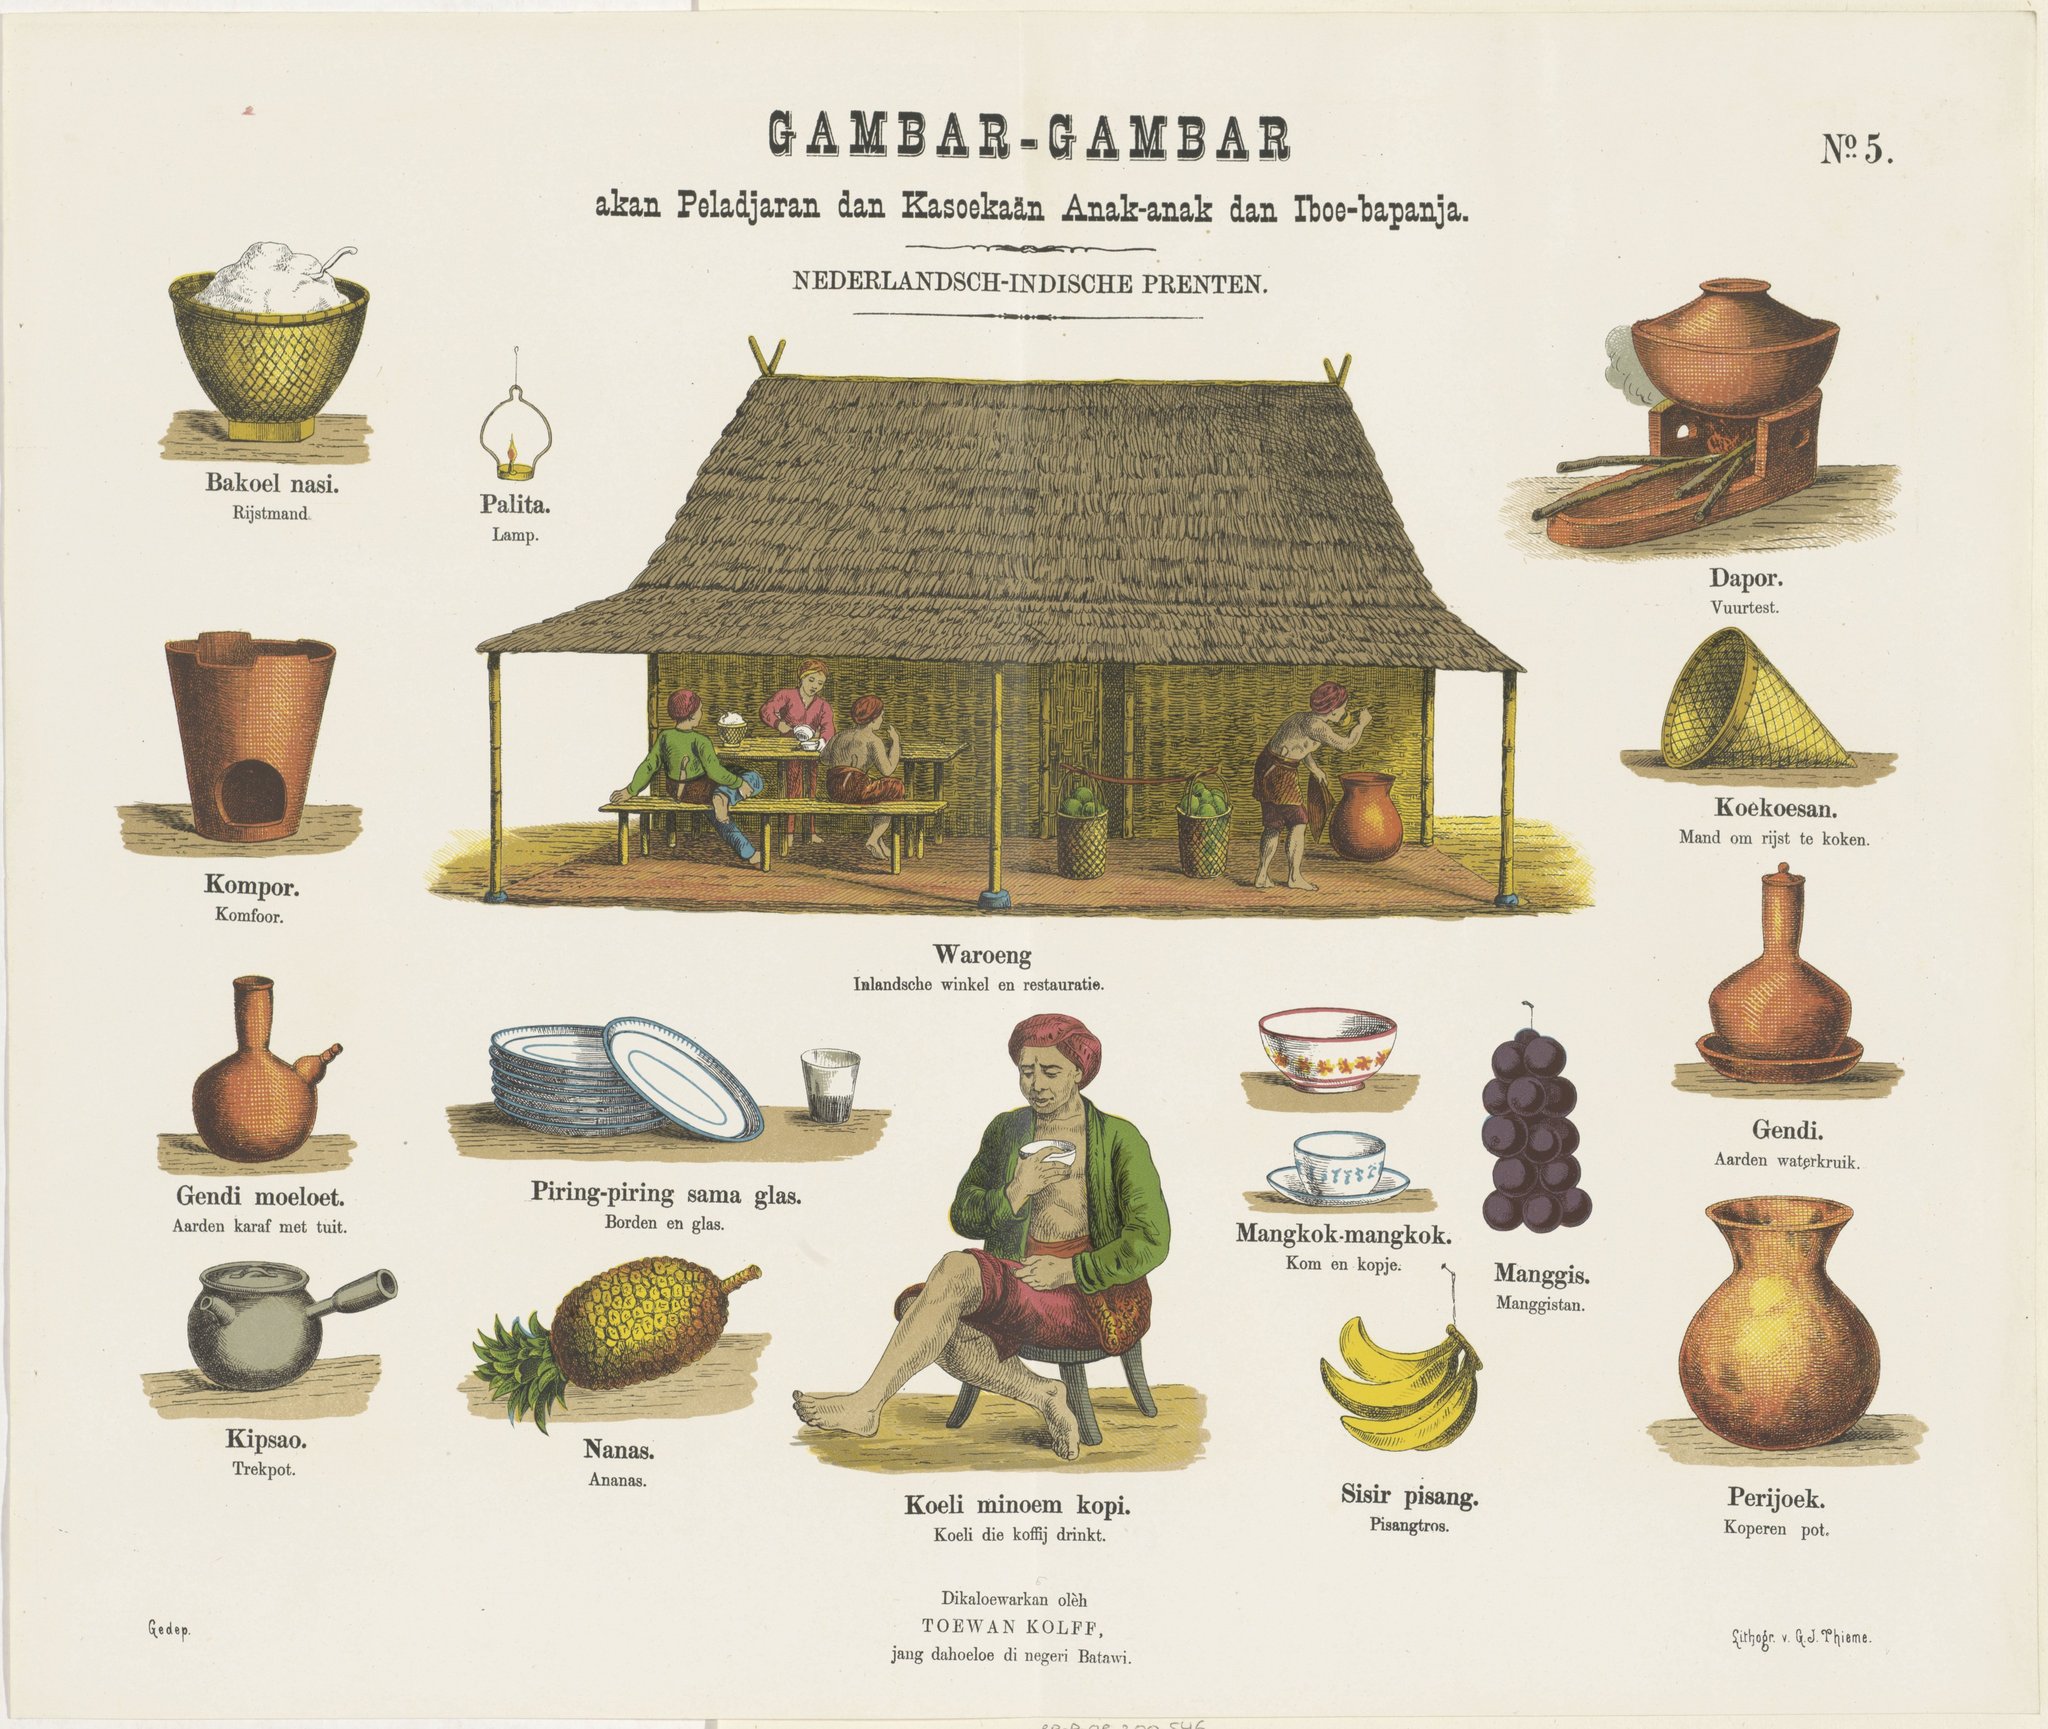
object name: print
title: Winkels en etenswaren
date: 1868-1881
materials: paper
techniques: lithograph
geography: leiden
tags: shop, store, asiatic races and peoples, working class, labourers, dinner-service, restaurant, fruits, dutch east indies, the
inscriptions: collector's mark: Lugt 2760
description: Blad met zeventien voorstellingen met betrekking tot een warung, een winkel en eetgelegenheid, in de voormalige kolonie Nederlands-Indië. Rondom de warung servies, andere keukenbenodigdheden, fruit en een contractarbeider die koffie drinkt. Onder elke afbeelding een onderschrift in het Maleis en het Nederlands. Genummerd rechtsboven: No. 5.